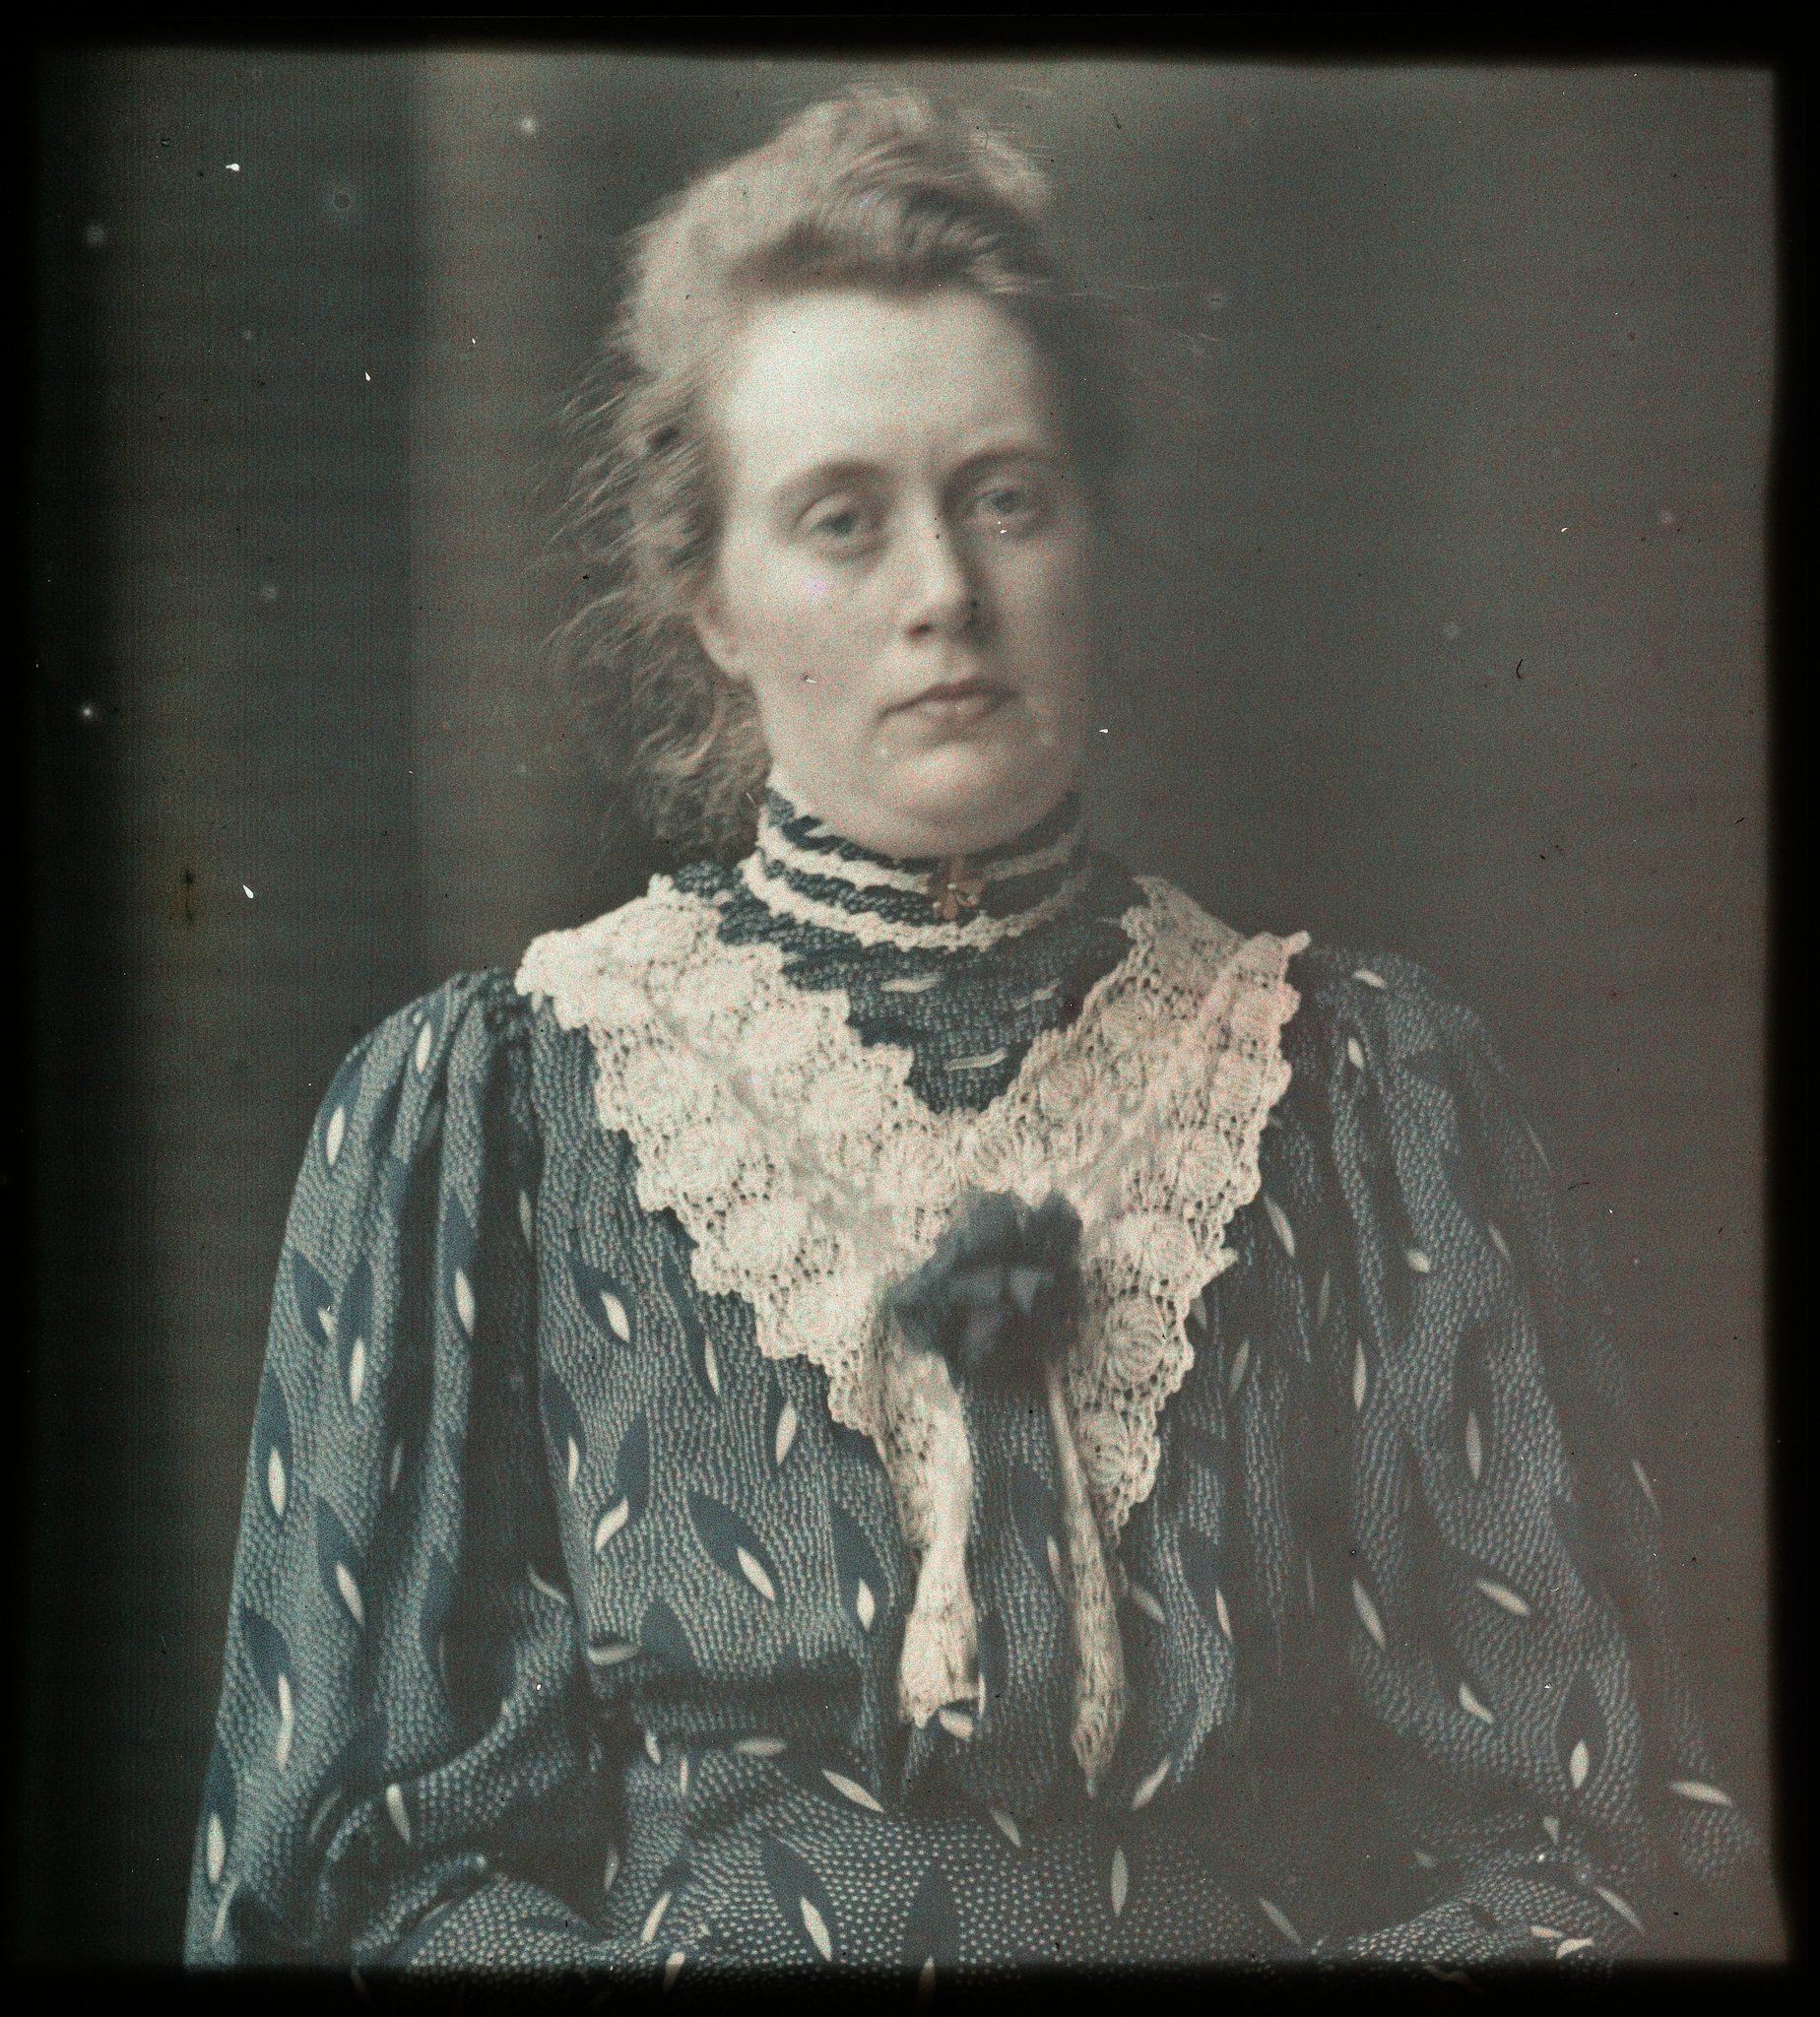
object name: photograph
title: Portret van een vrouw, gekleed in een blauwe jurk of blouse en een witte kraag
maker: Anonymous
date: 1907-1930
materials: glass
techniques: autochrome process, slide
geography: netherlands